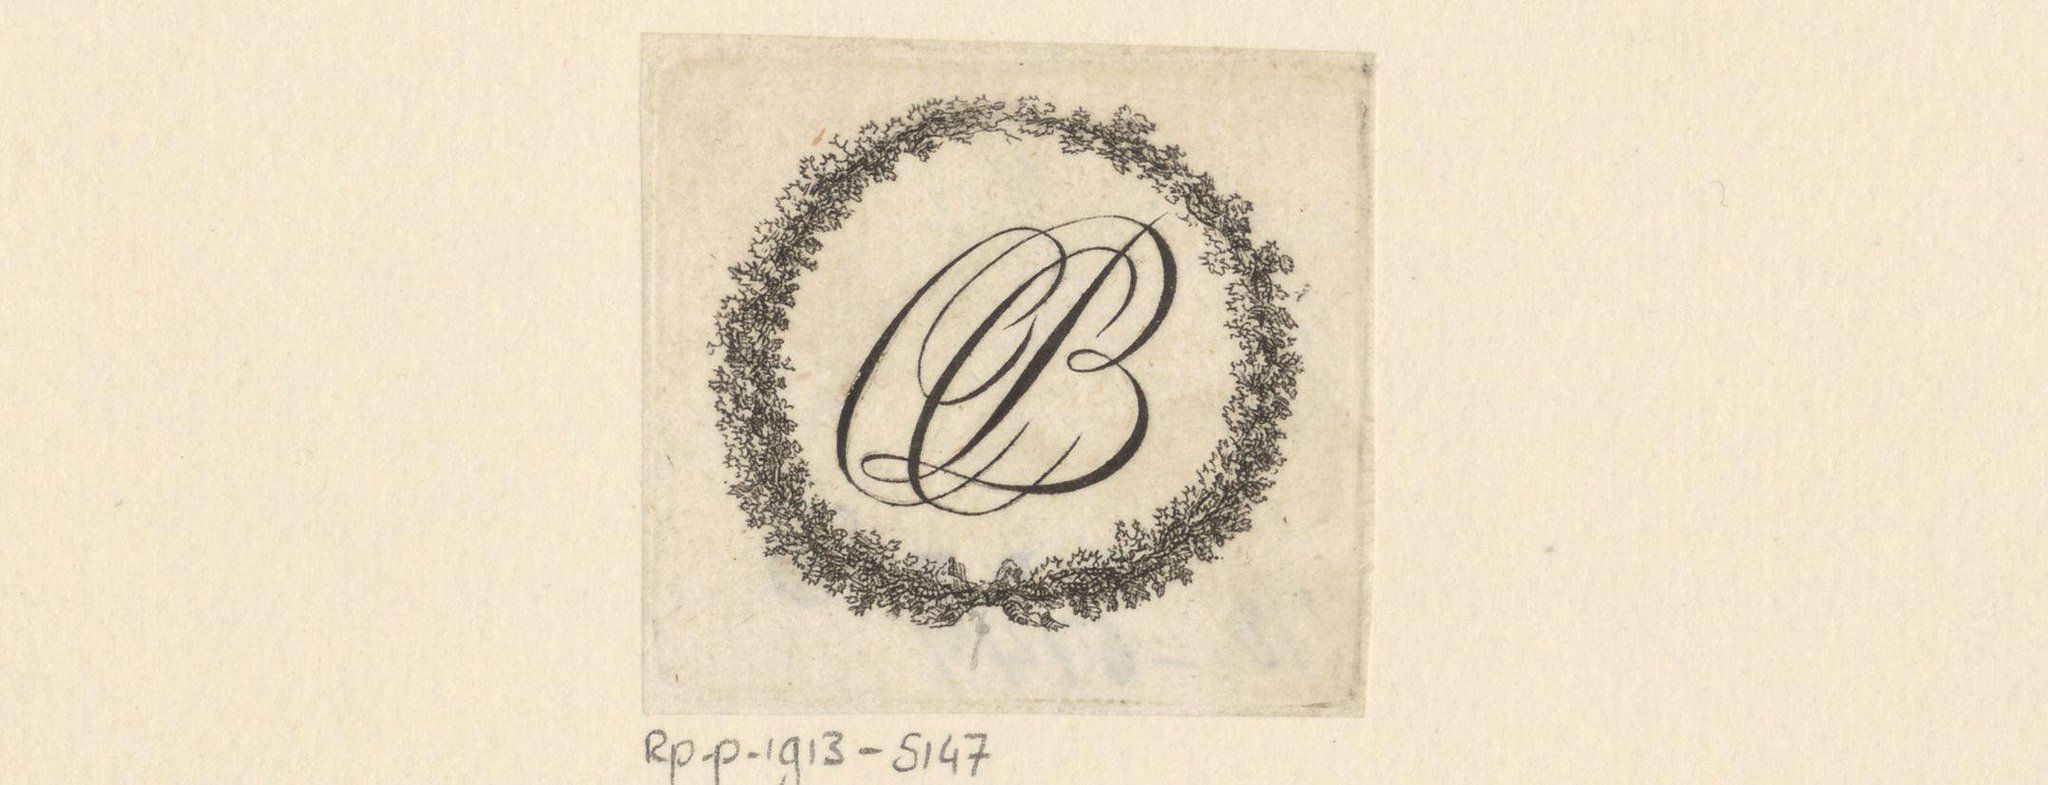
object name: bookplate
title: Ex libris van C.C.B.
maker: Anonymous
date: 1750-1849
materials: paper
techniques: etching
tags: garland, wreath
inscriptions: collector's mark: Lugt 2233, collector's mark: Lugt 2760